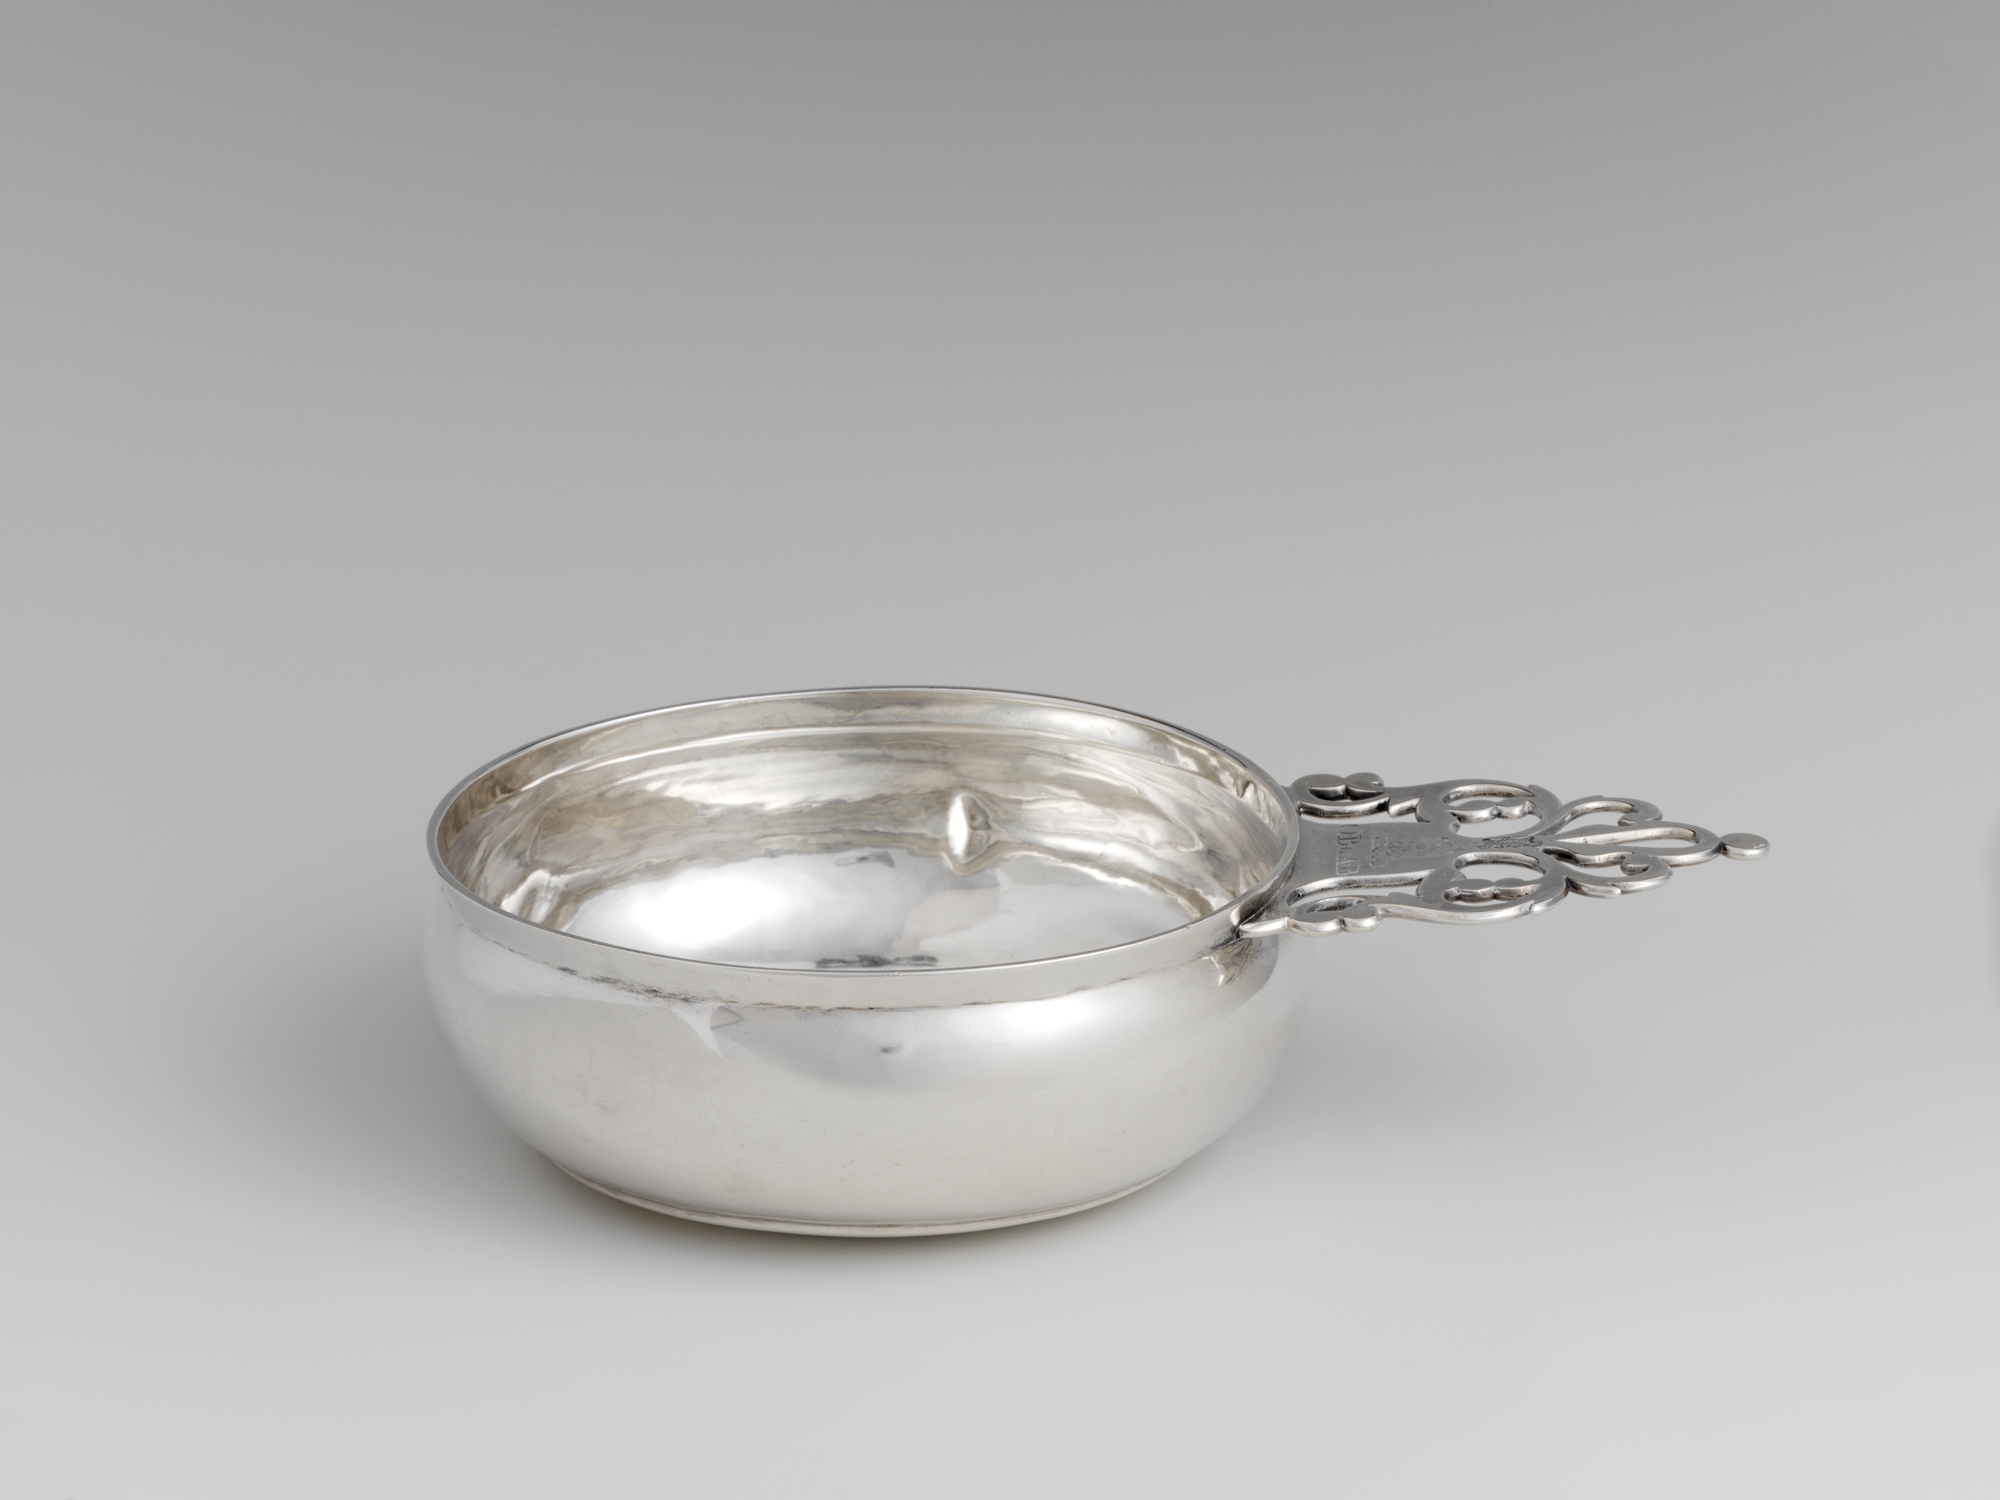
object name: porringer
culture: american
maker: benjamin burt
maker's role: maker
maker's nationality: american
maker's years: 1729-1805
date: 1763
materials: silver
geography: united states